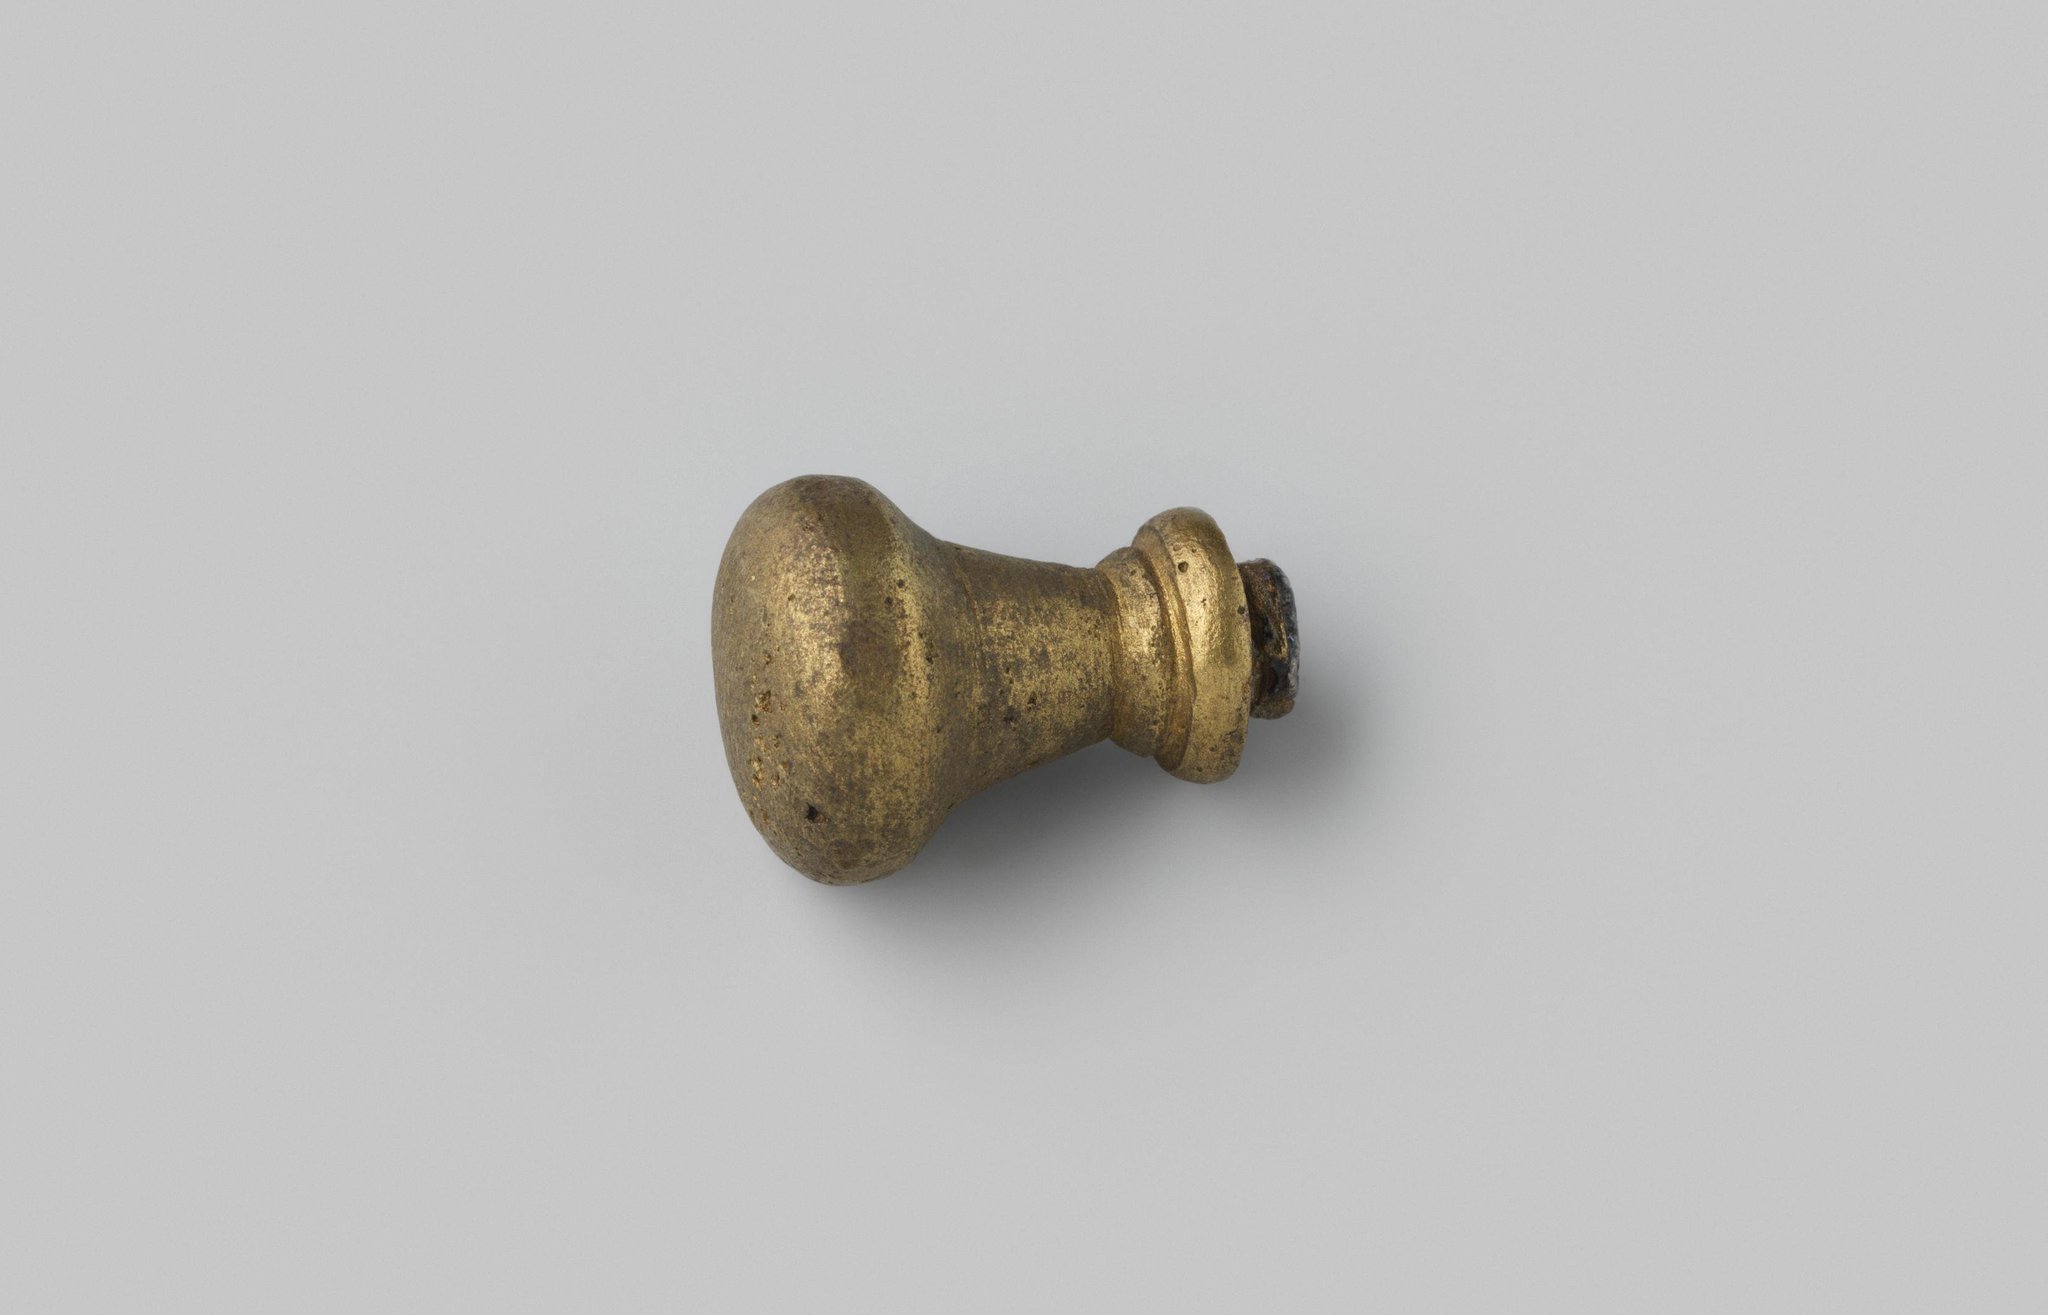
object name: knob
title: Knop uit het wrak van de Oost-Indiëvaarder Hollandia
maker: Anonymous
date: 1700-1743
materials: copper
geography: netherlands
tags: verenigde oostindische compagnie, hollandia (schip), annet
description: Fitting, knob; inverted baluster, flattened top, stepped base, tenon with solder projecting.